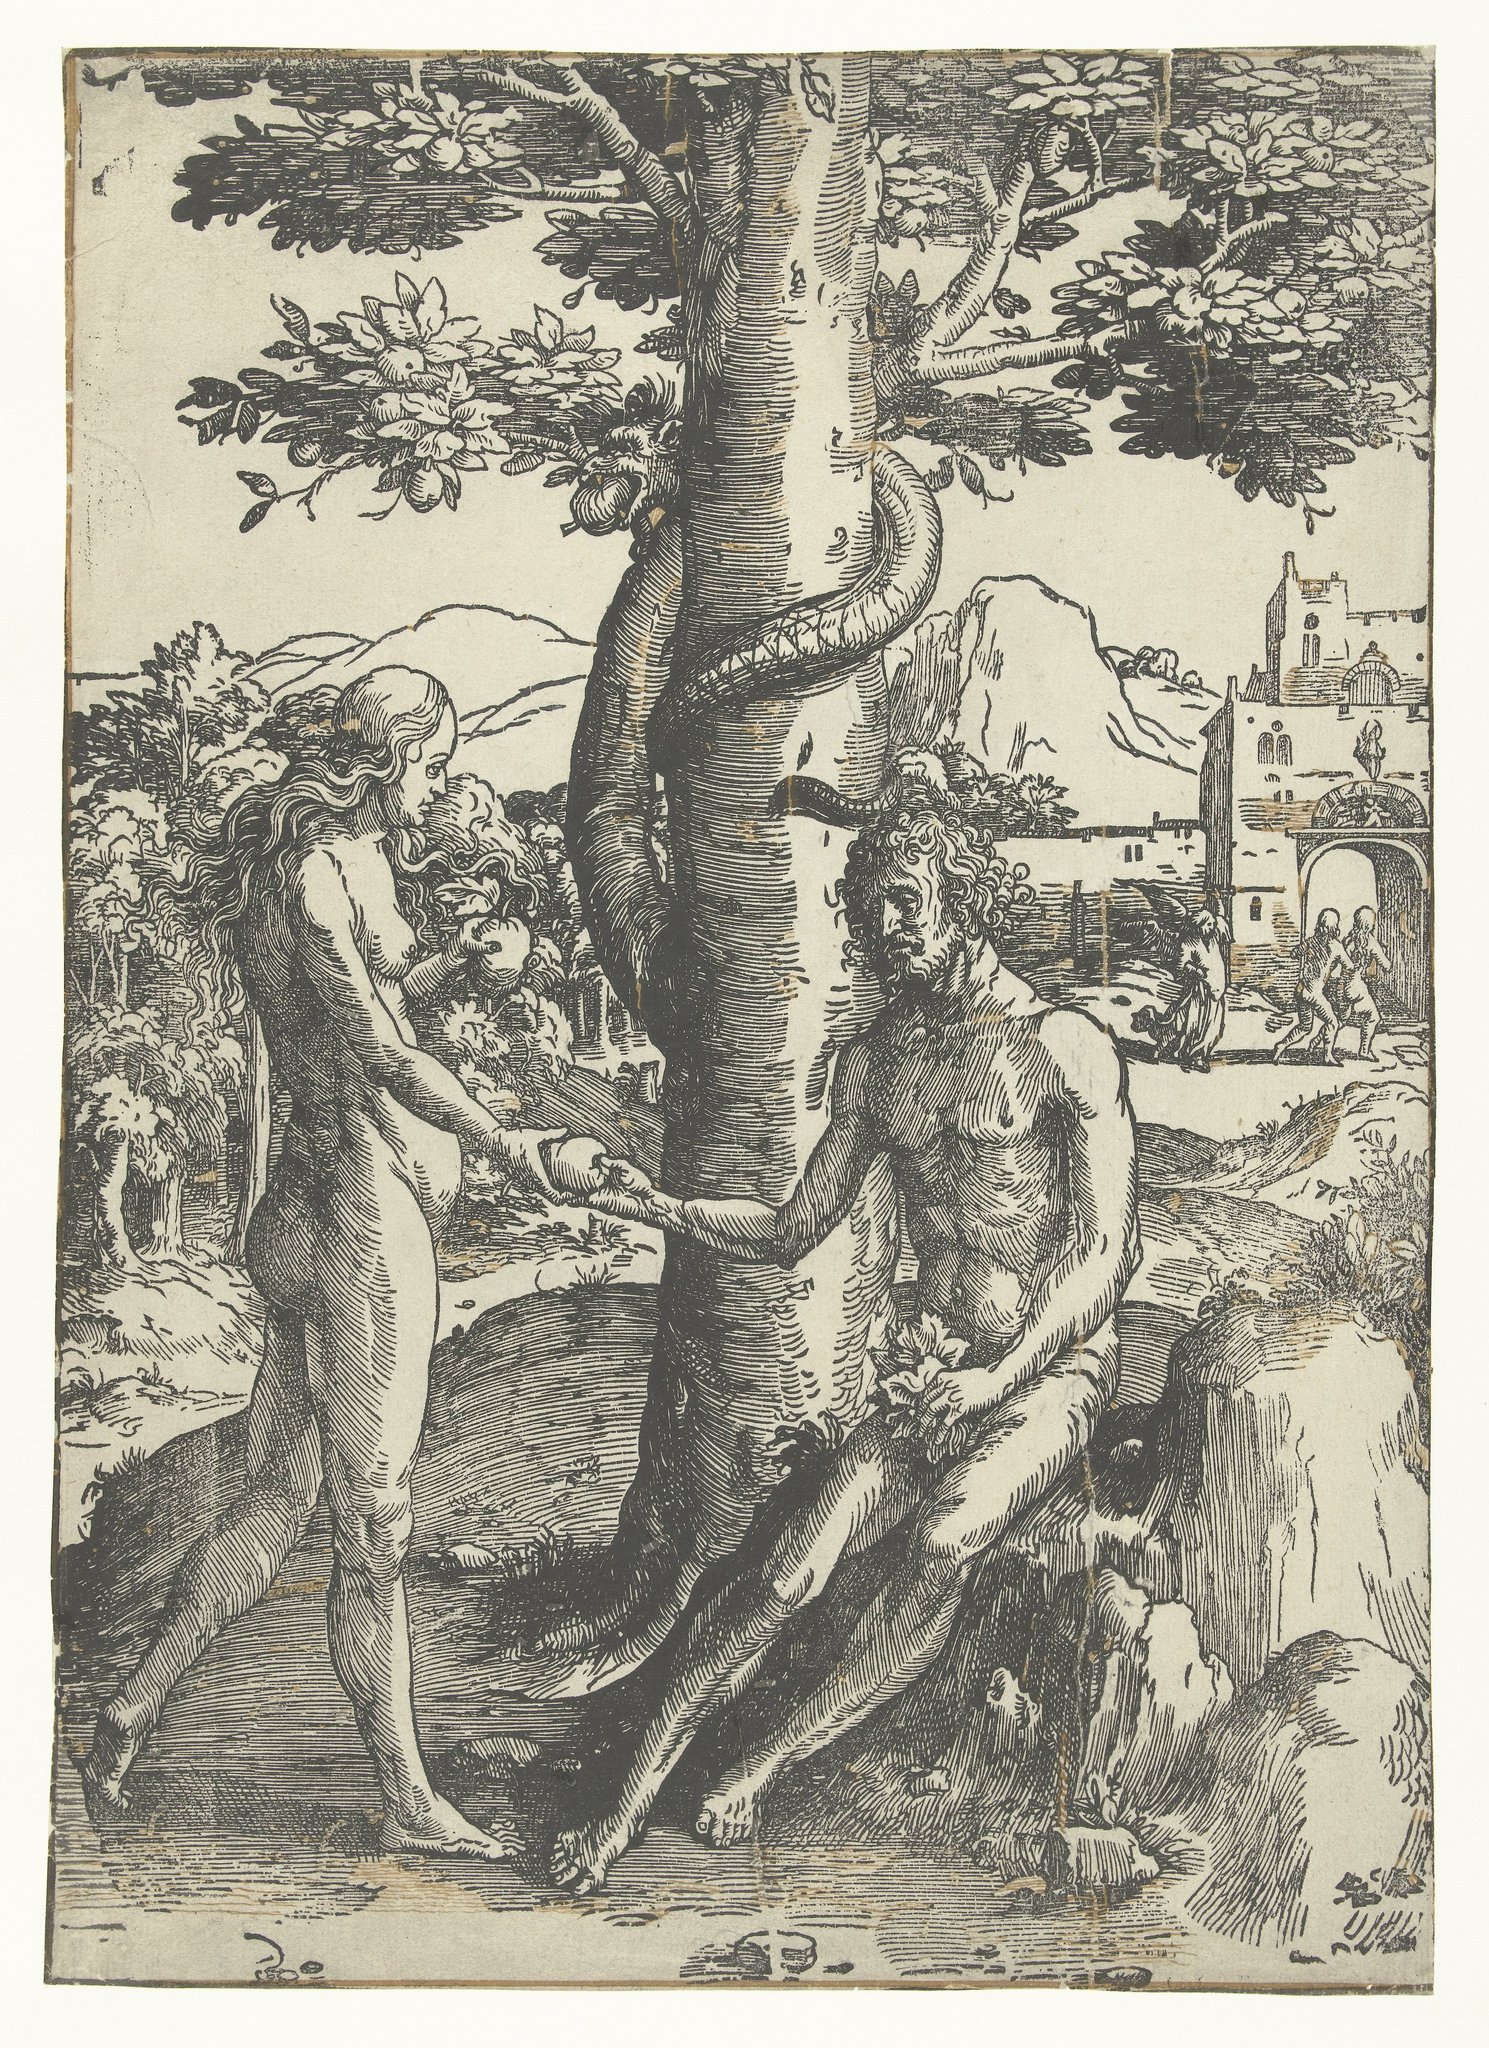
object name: print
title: De zondeval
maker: lucas van leyden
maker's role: draughtsman, painter, print maker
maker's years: 1494-1533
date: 1512-1516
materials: paper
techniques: retouching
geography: low countries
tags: eve offers the fruit to adam, an angel chases adam and eve out of paradise with a (flaming) sword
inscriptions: collector's mark: Lugt 240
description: Eva overhandigt Adam de verboden vrucht. Rechts op de achtergrond de verdrijving uit het Paradijs.